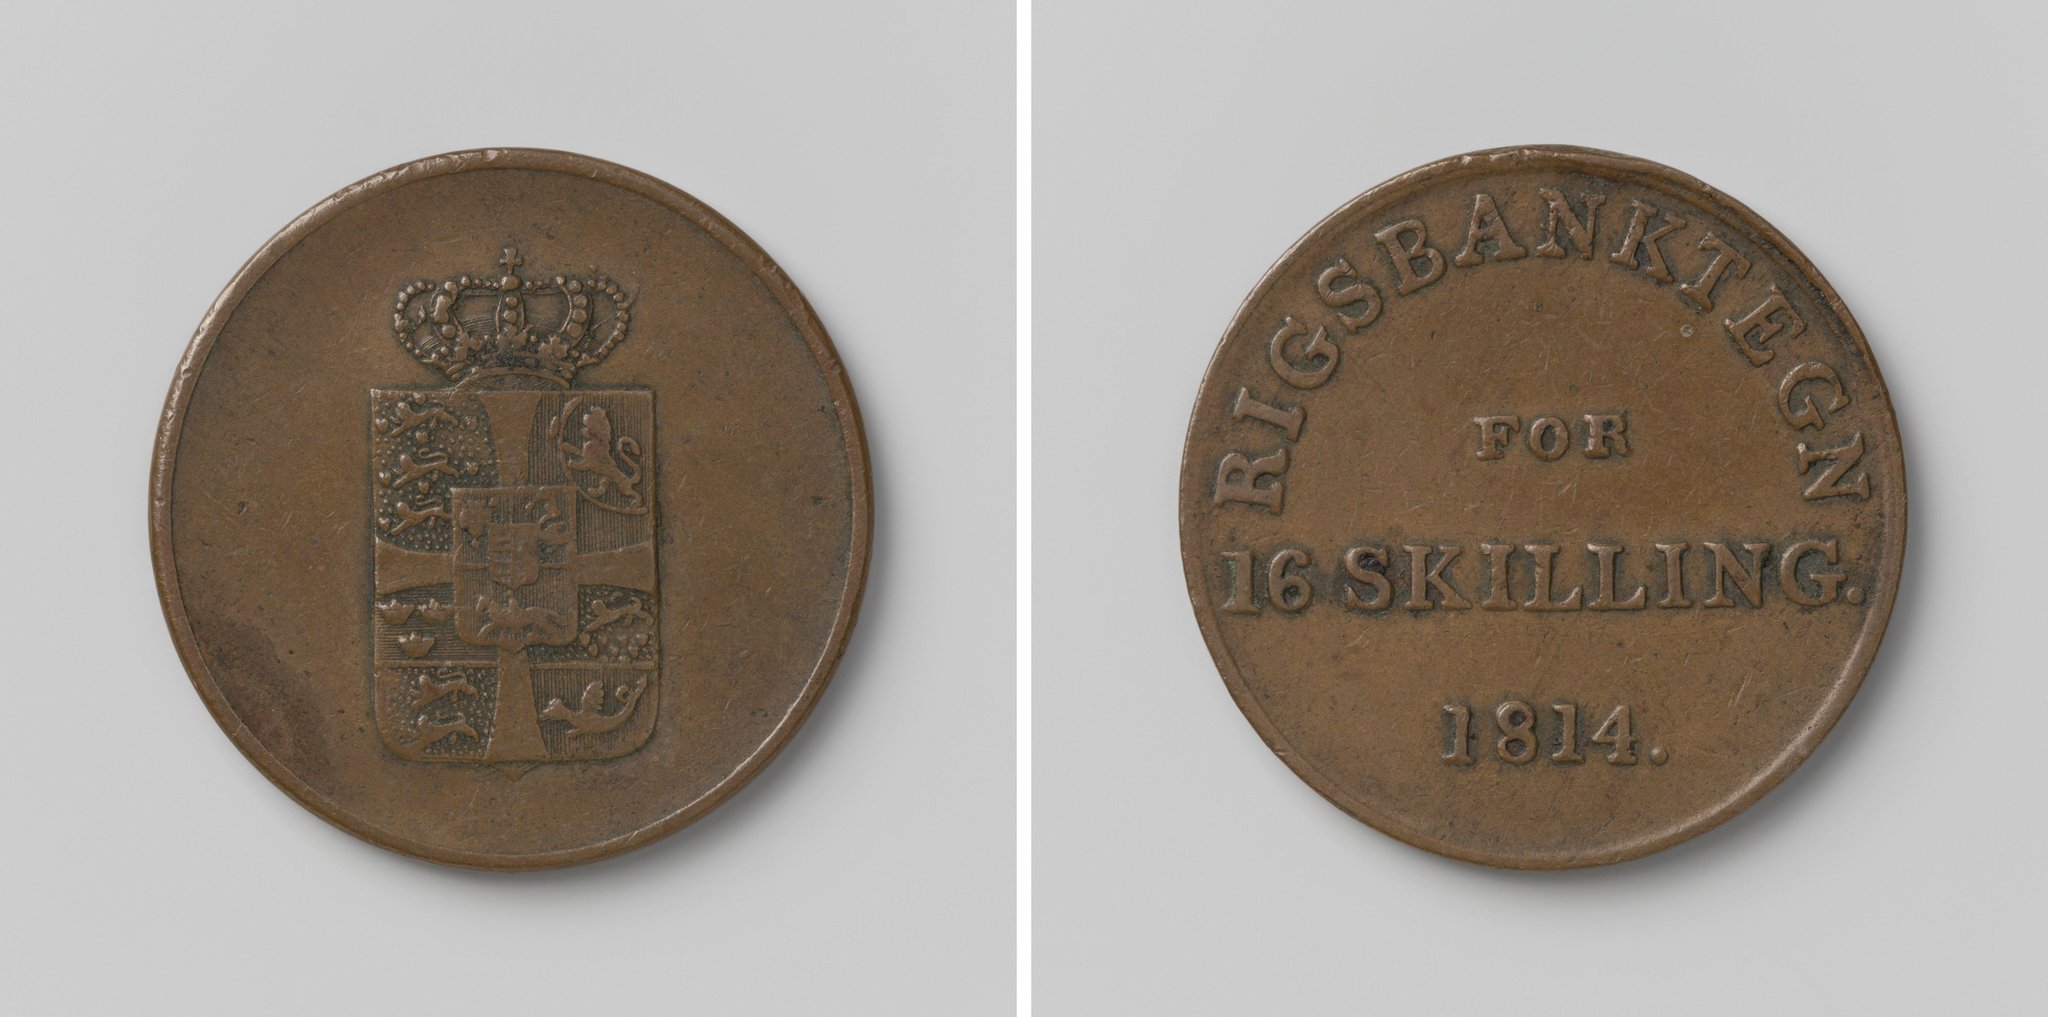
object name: coin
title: Zestien skilling, noodmunt van Frederik VI, koning van Denemarken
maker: Anonymous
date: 1814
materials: copper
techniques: striking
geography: denmark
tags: frederik vi (koning van denemarken en noorwegen), napoleontische oorlogen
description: Koperen noodmunt. Voorzijde: gekroond wapenschild. Keerzijde: opschrift binnen omschrift.